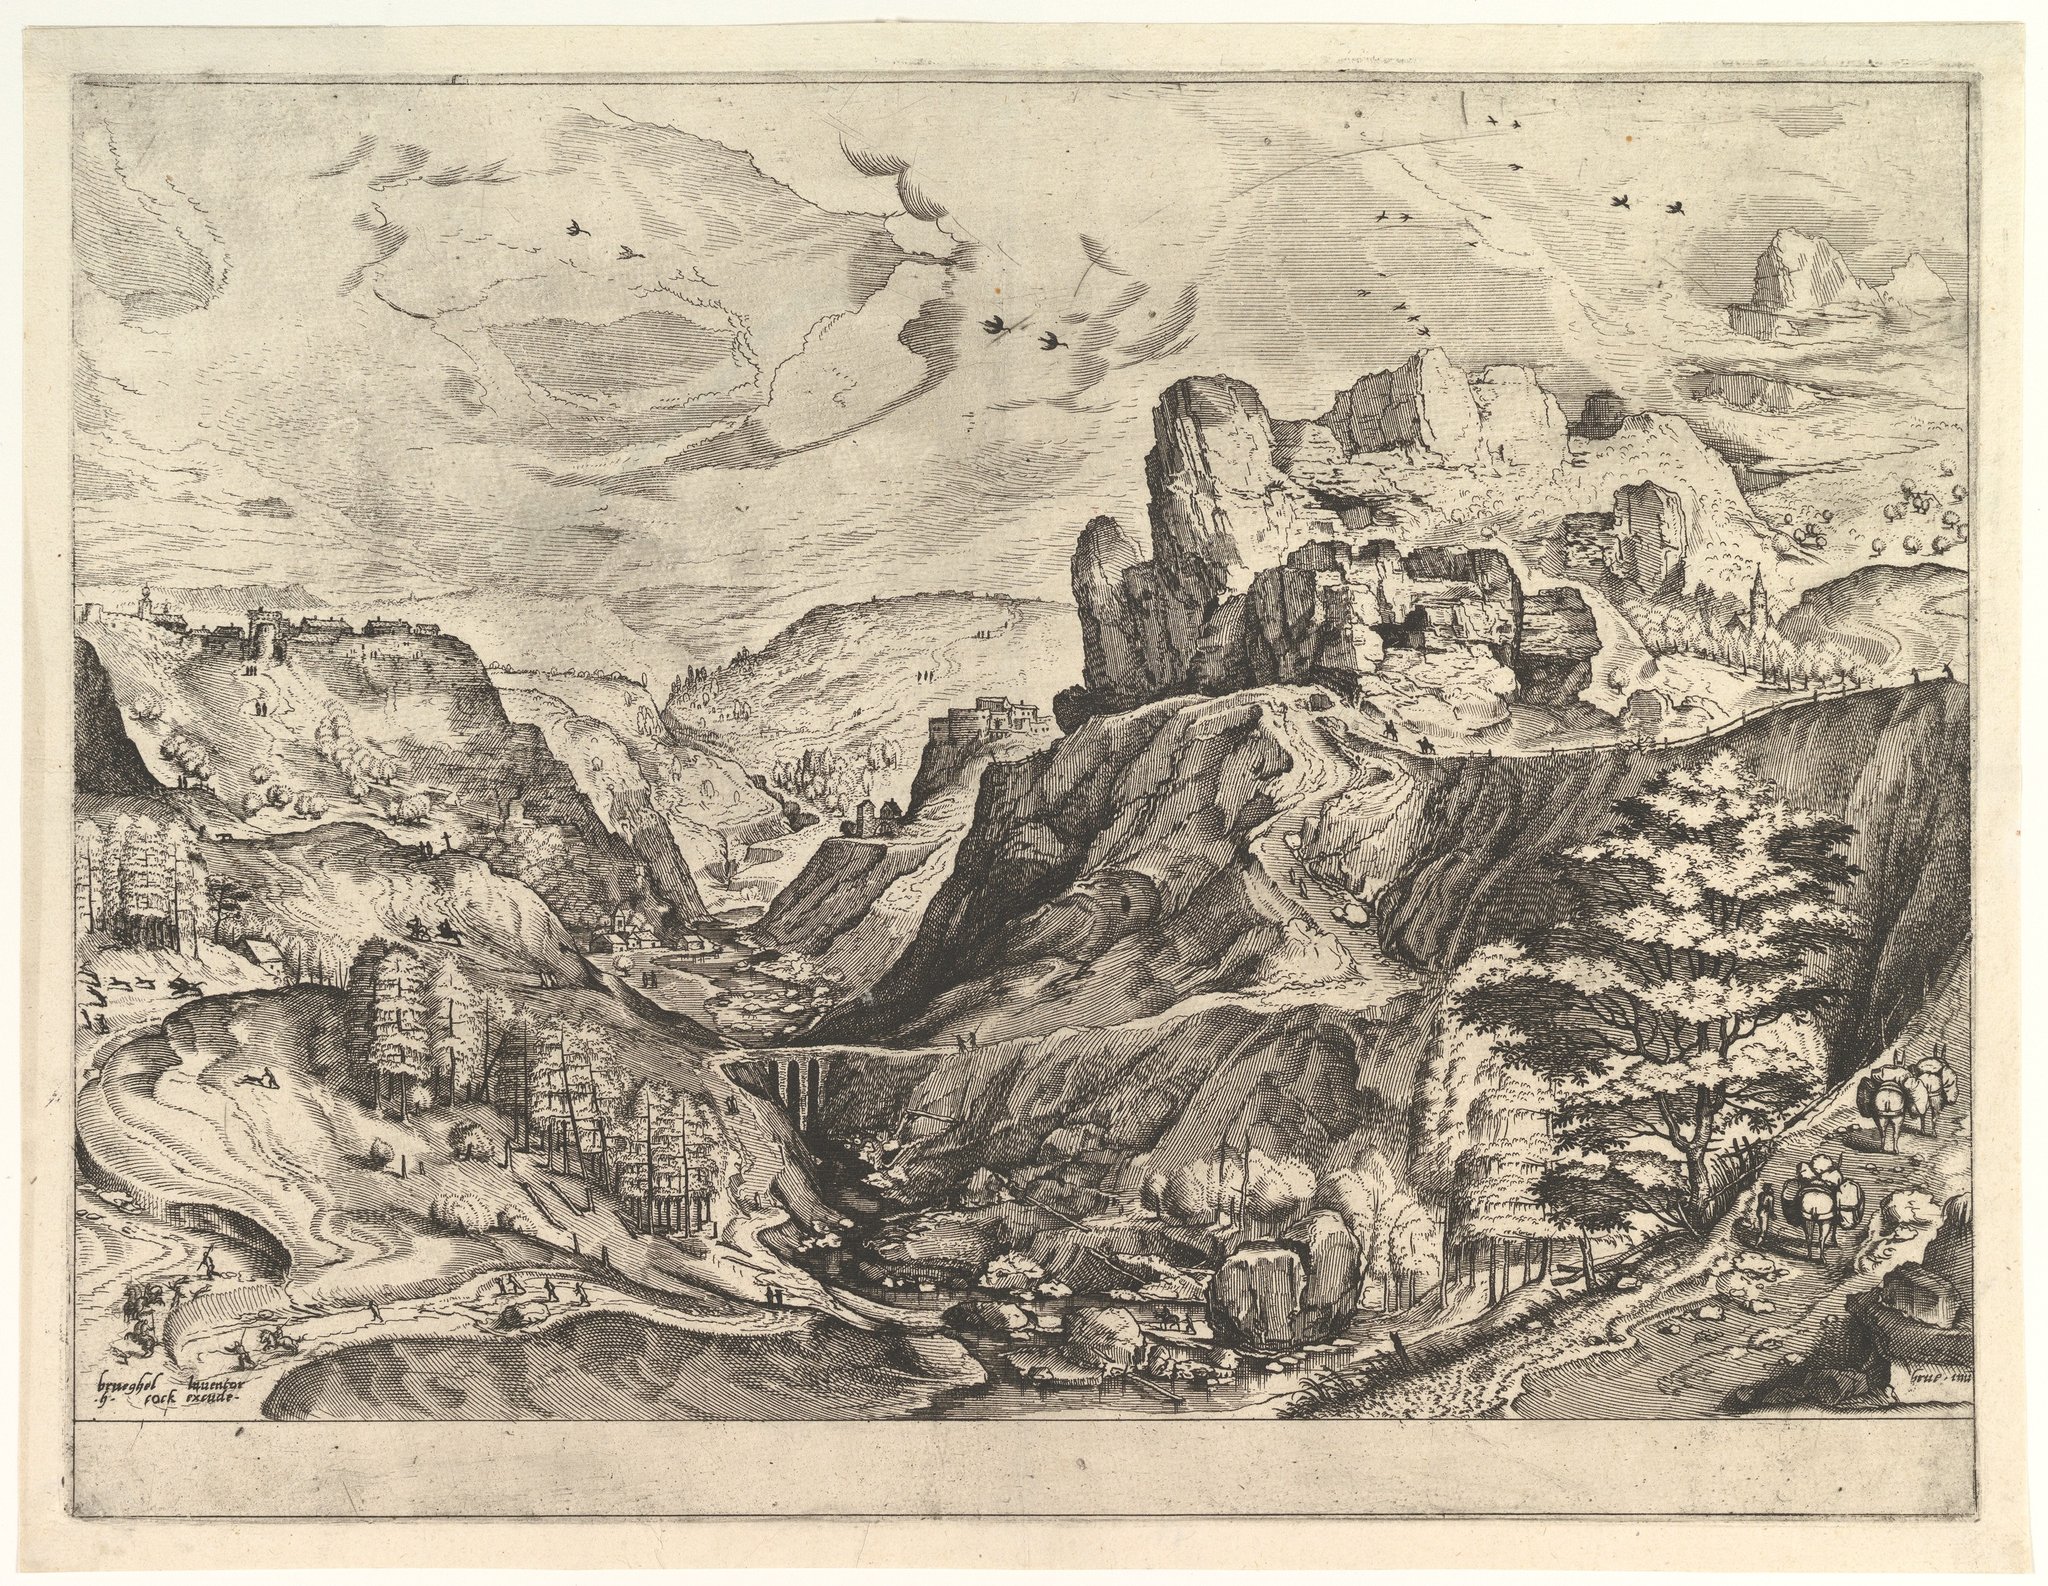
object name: print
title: Alpine Landscape with a Deep Valley, from "The Large Landscapes"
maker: johannes van doetecum i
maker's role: artist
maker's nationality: netherlandish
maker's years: 1528-1605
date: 1555-1556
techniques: engraving, etching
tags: landscapes